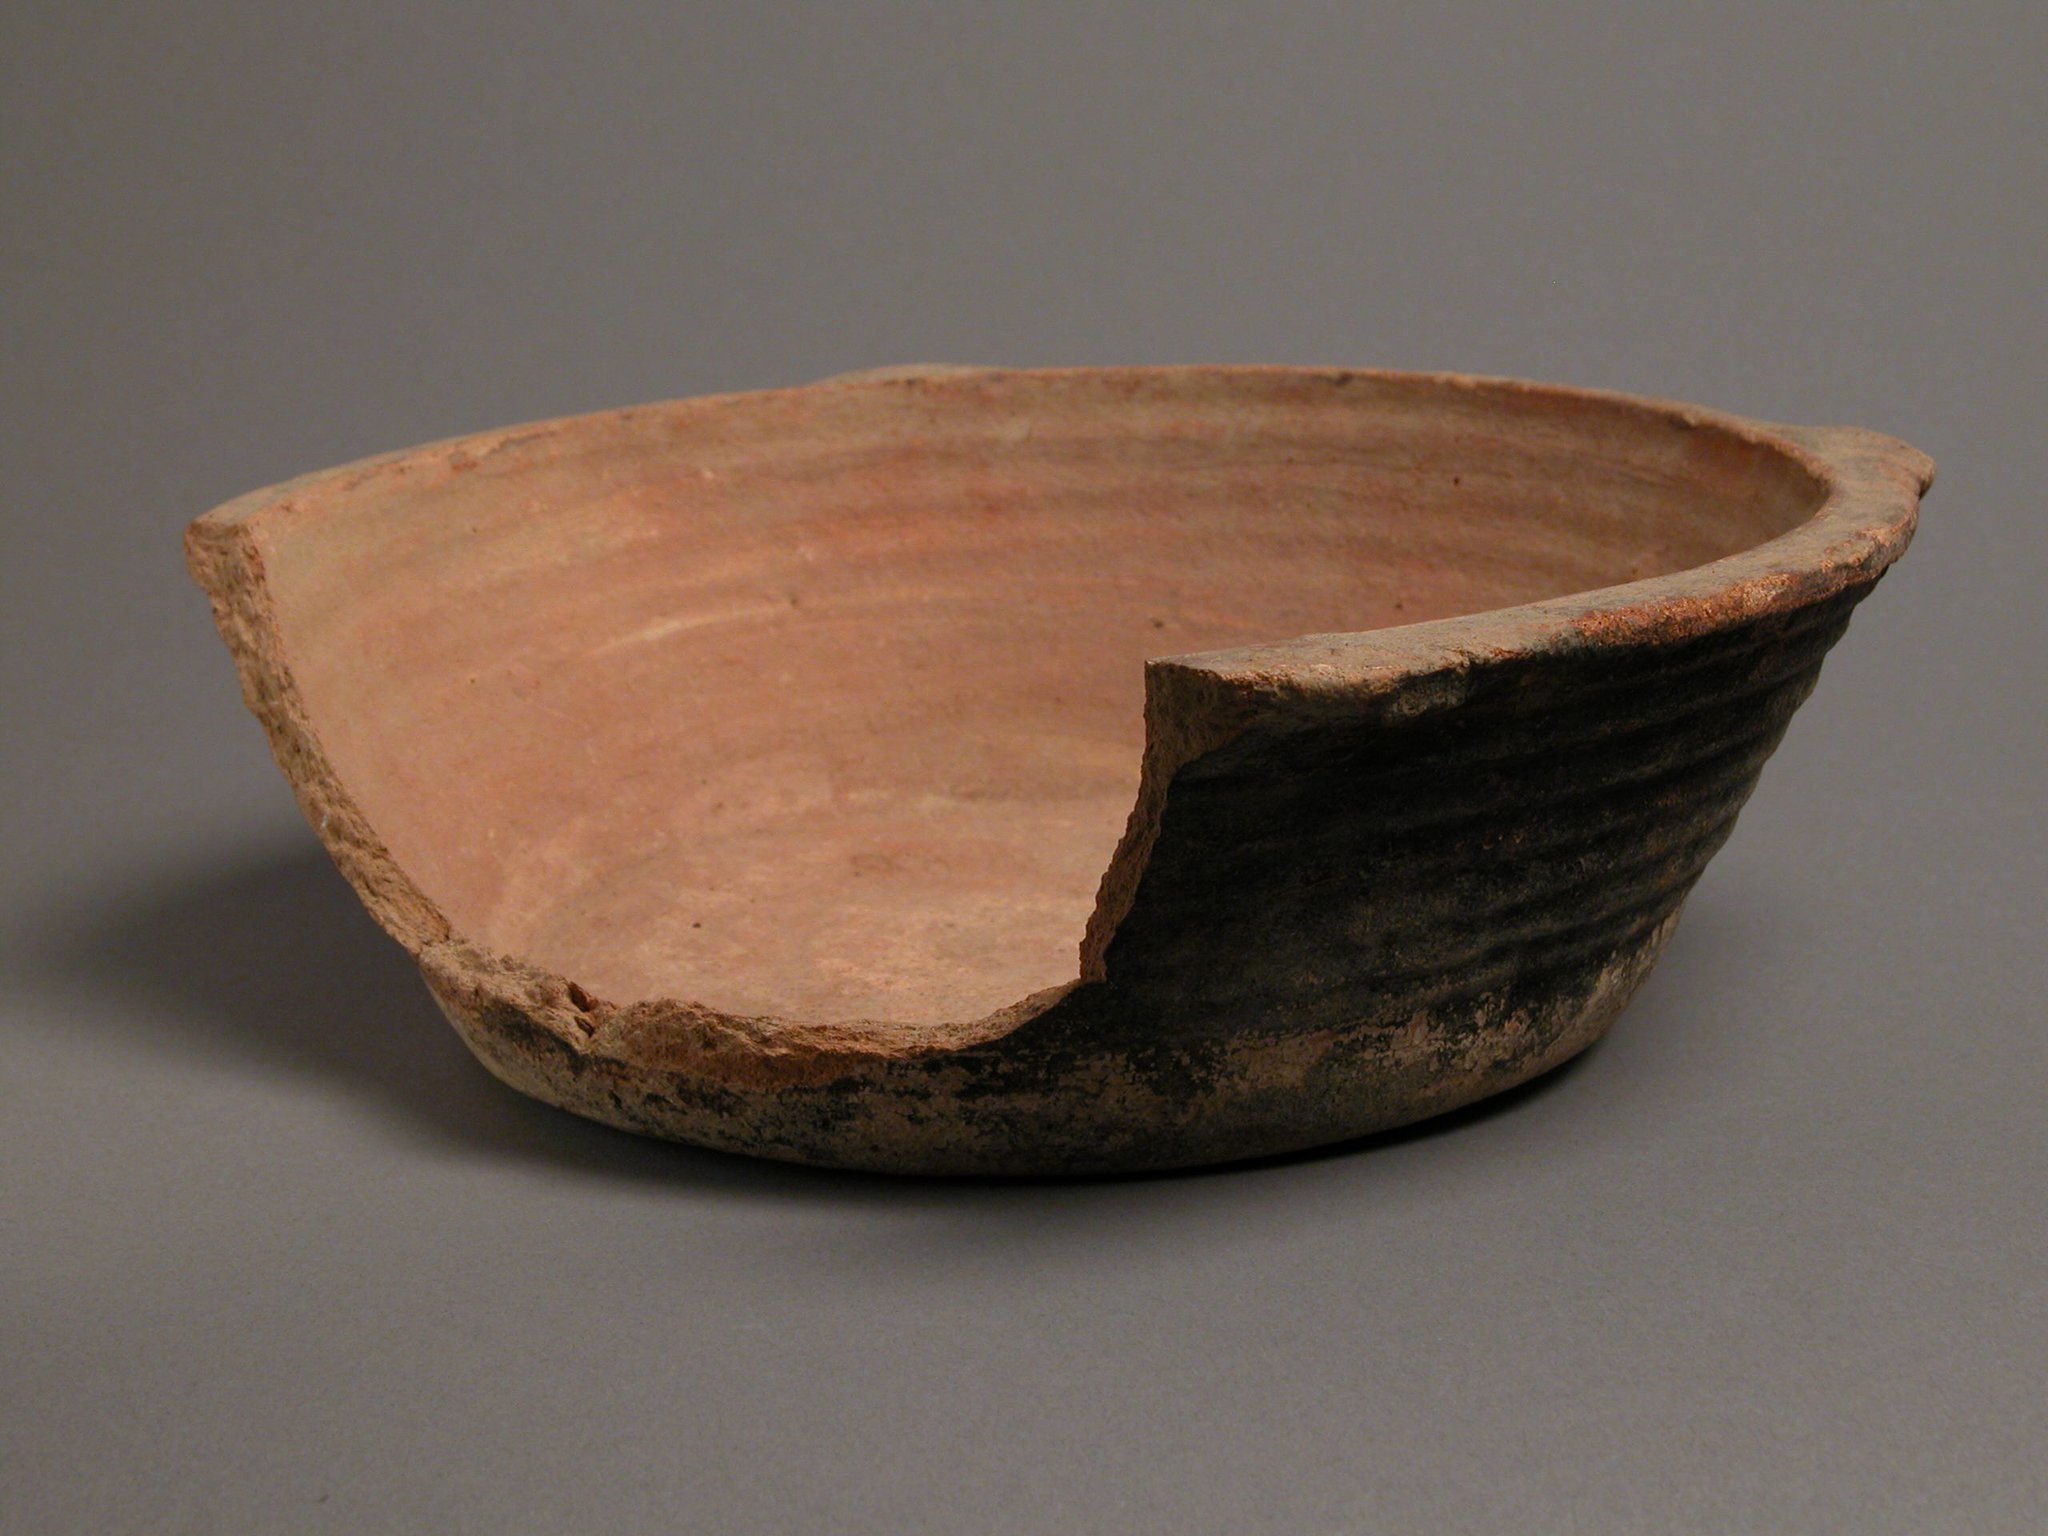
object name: bowl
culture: coptic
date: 301-700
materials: earthenware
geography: egypt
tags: bowls